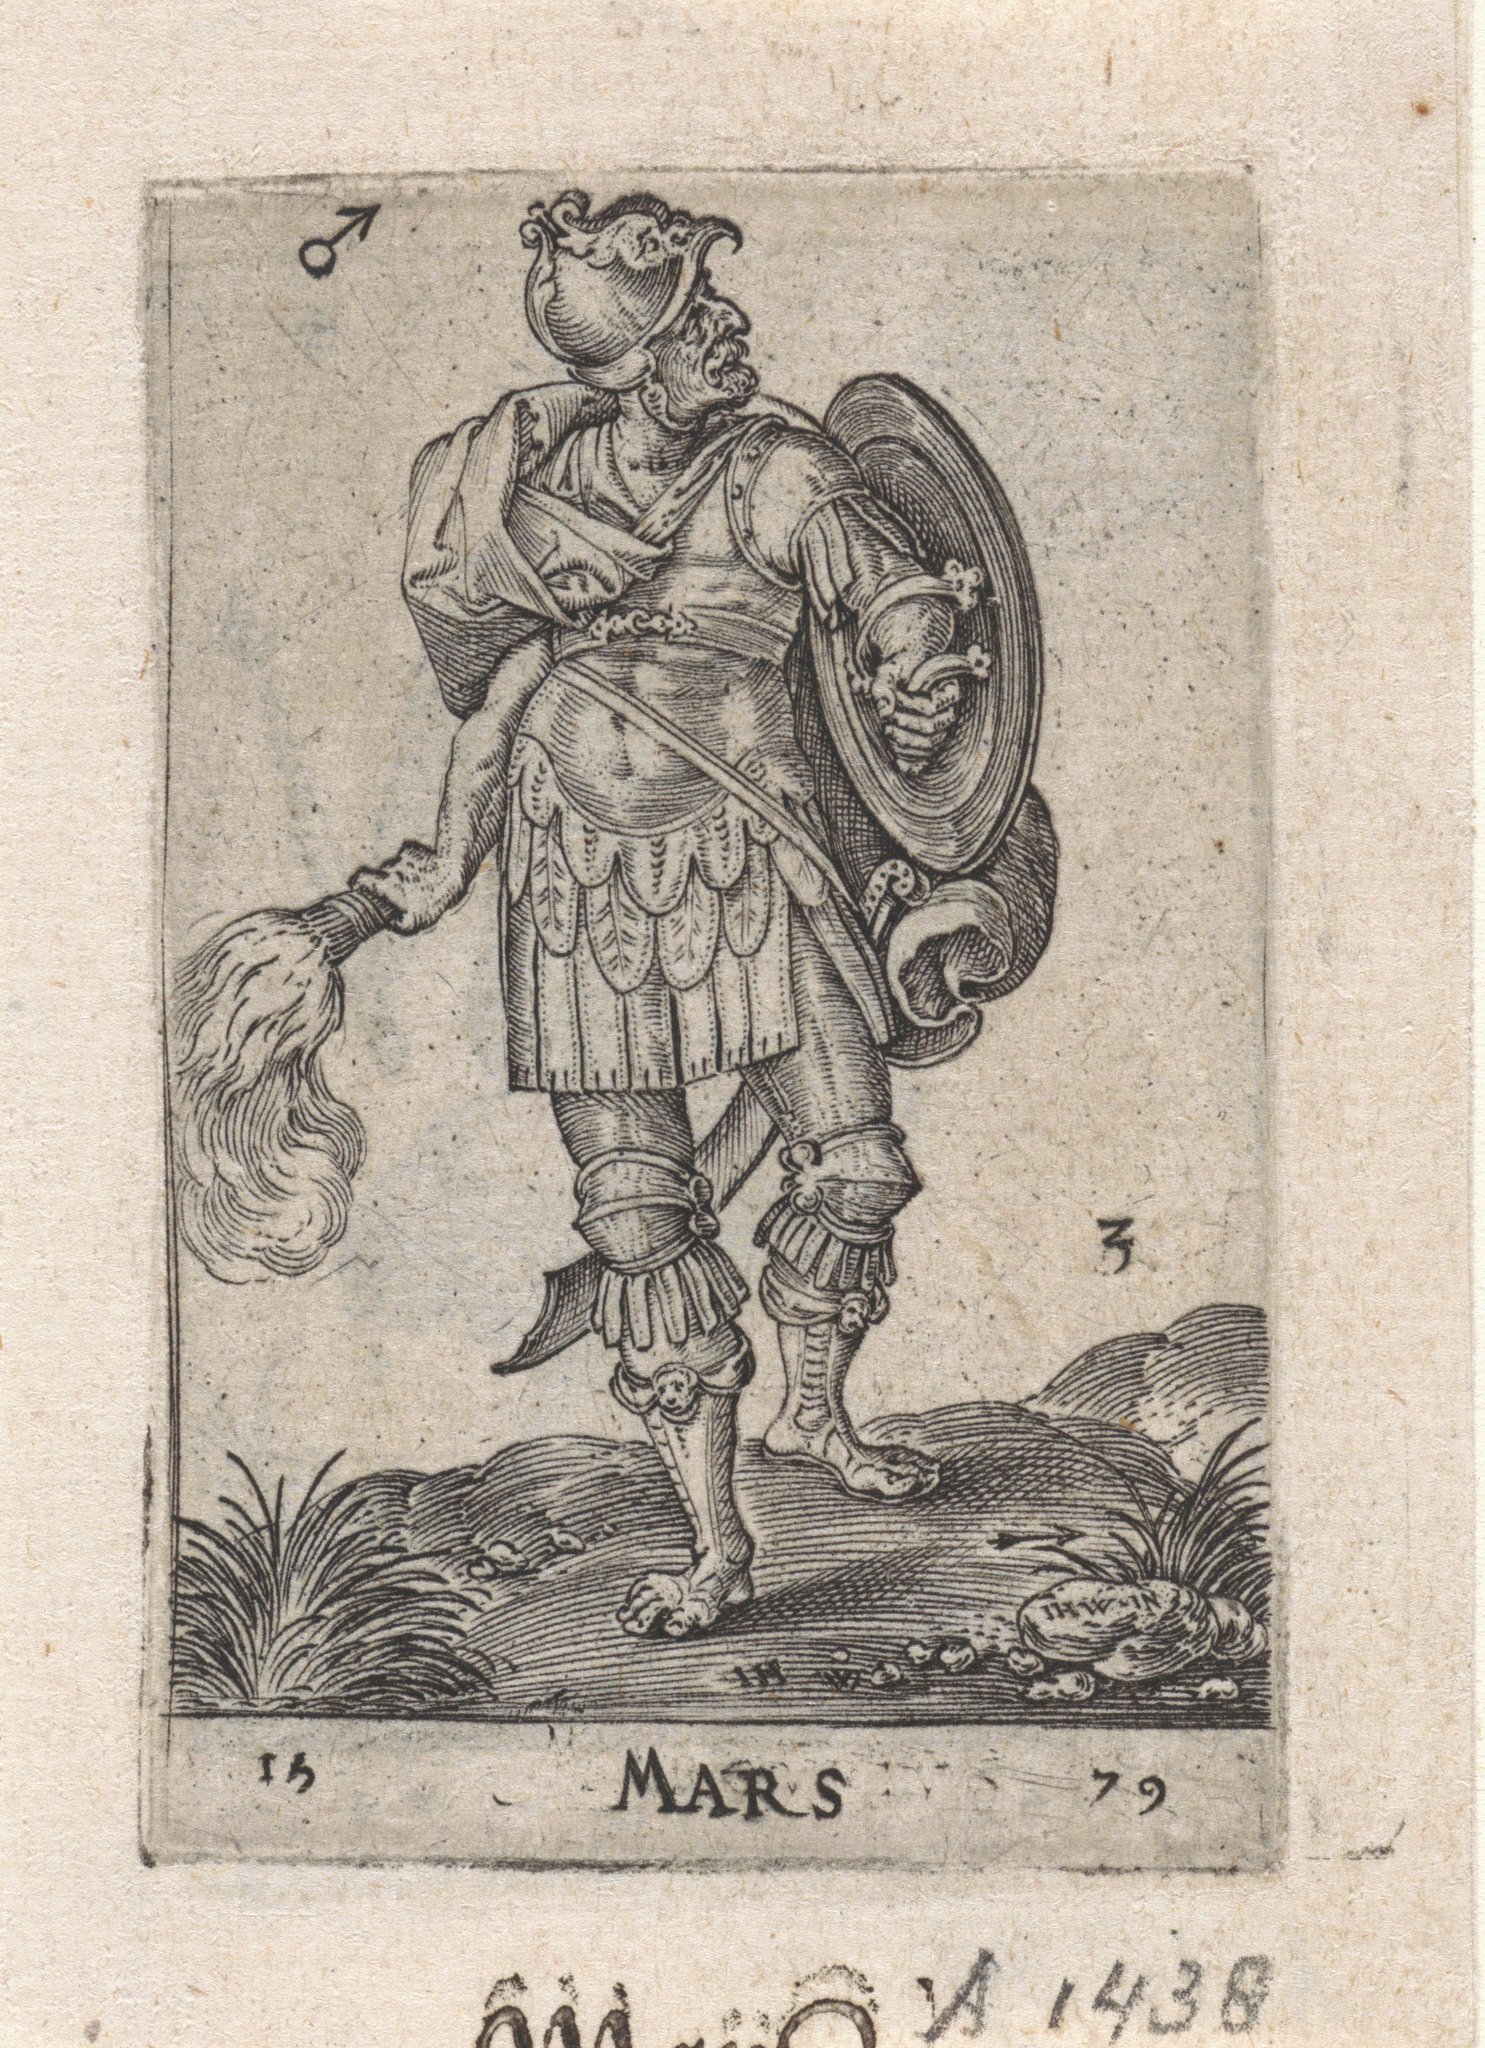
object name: print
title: Mars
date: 1579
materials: paper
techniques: engraving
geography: delft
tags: mars (planet)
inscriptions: inscription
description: Prent gebruikt als illustratie in: Const-toonneel, inhoudende de beschrijvinghe ende XL. Heerlijcke afbeeldindinghen: Onses Heeren Jesu Christi, met sijne apostelen, ende evangelisten, midtsgaders de hooft-deuchden ende ondeuchden. Ende ten laetsten de seven planeten. In coper gesneden door Johannis Wierix. De beschrijvinge is (...). Delft: Nicolaes de Clerck, 1609.